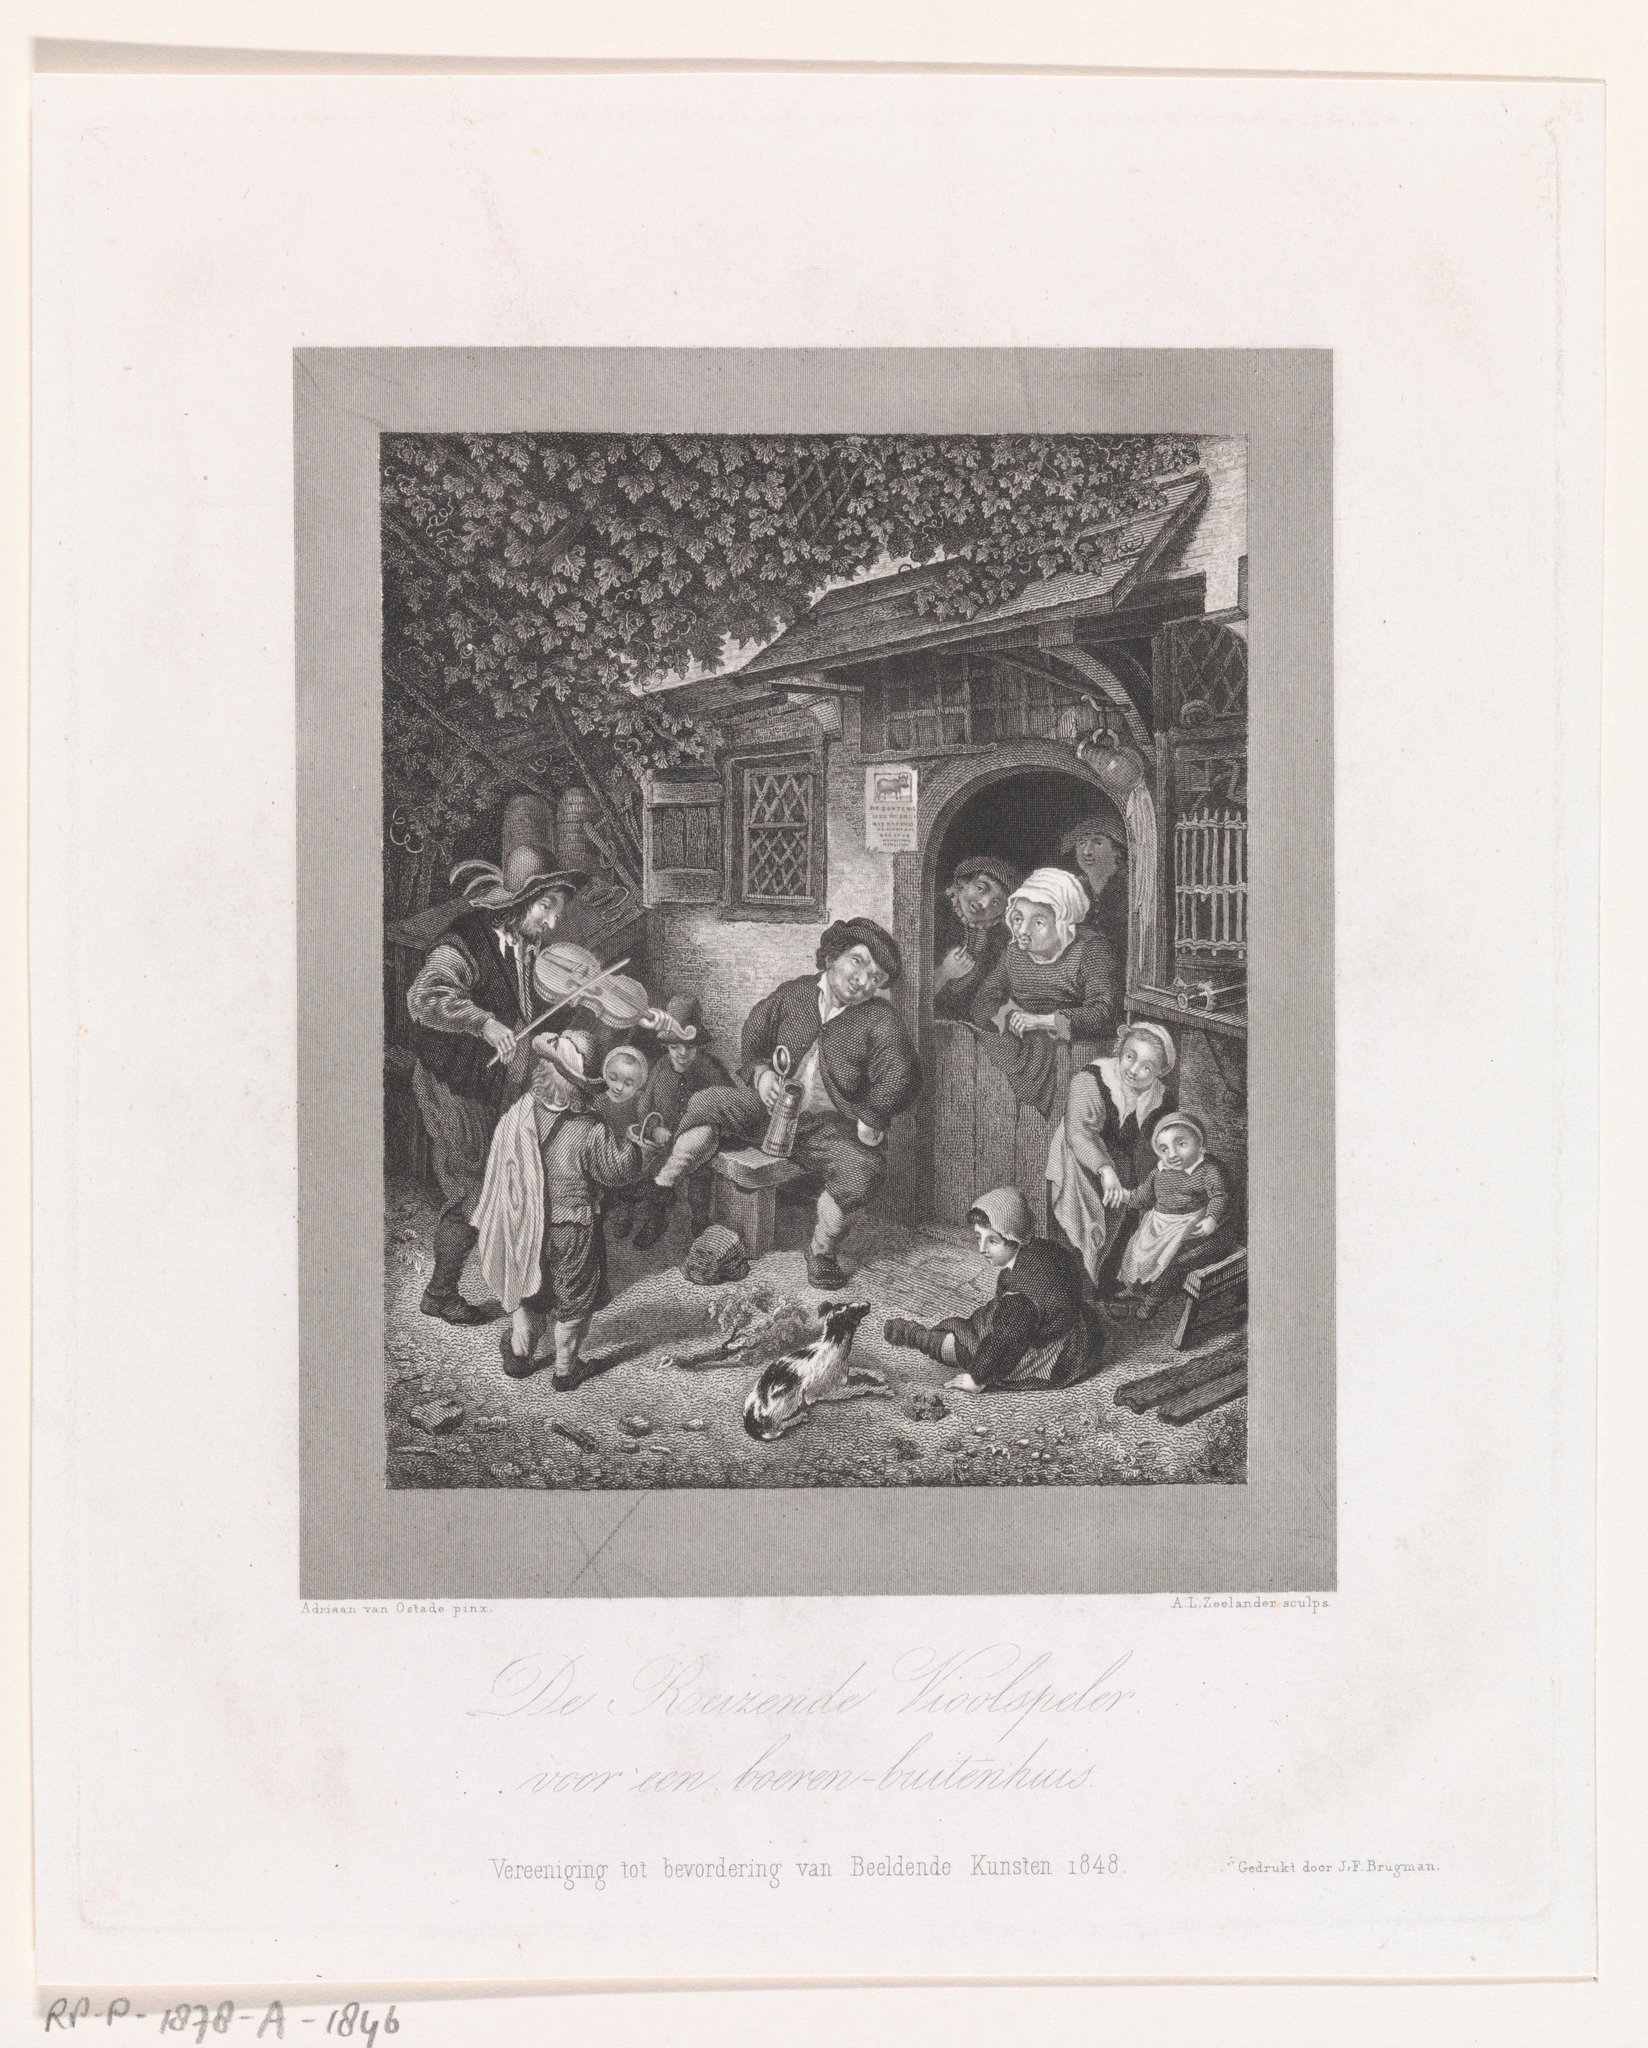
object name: print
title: De Reizende Vioolspeler voor een boeren-buitenhuis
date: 1848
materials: paper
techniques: engraving, etching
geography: amsterdam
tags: one person playing string instrument (bowed), inn, coffee-house, public house, etc., dog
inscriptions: collector's mark: Lugt 2228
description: Een man met viool en een jongen met draailier maken muziek bij een herberg. Volwassenen en kinderen luisteren. Een vrouw leunt over de onderdeur.